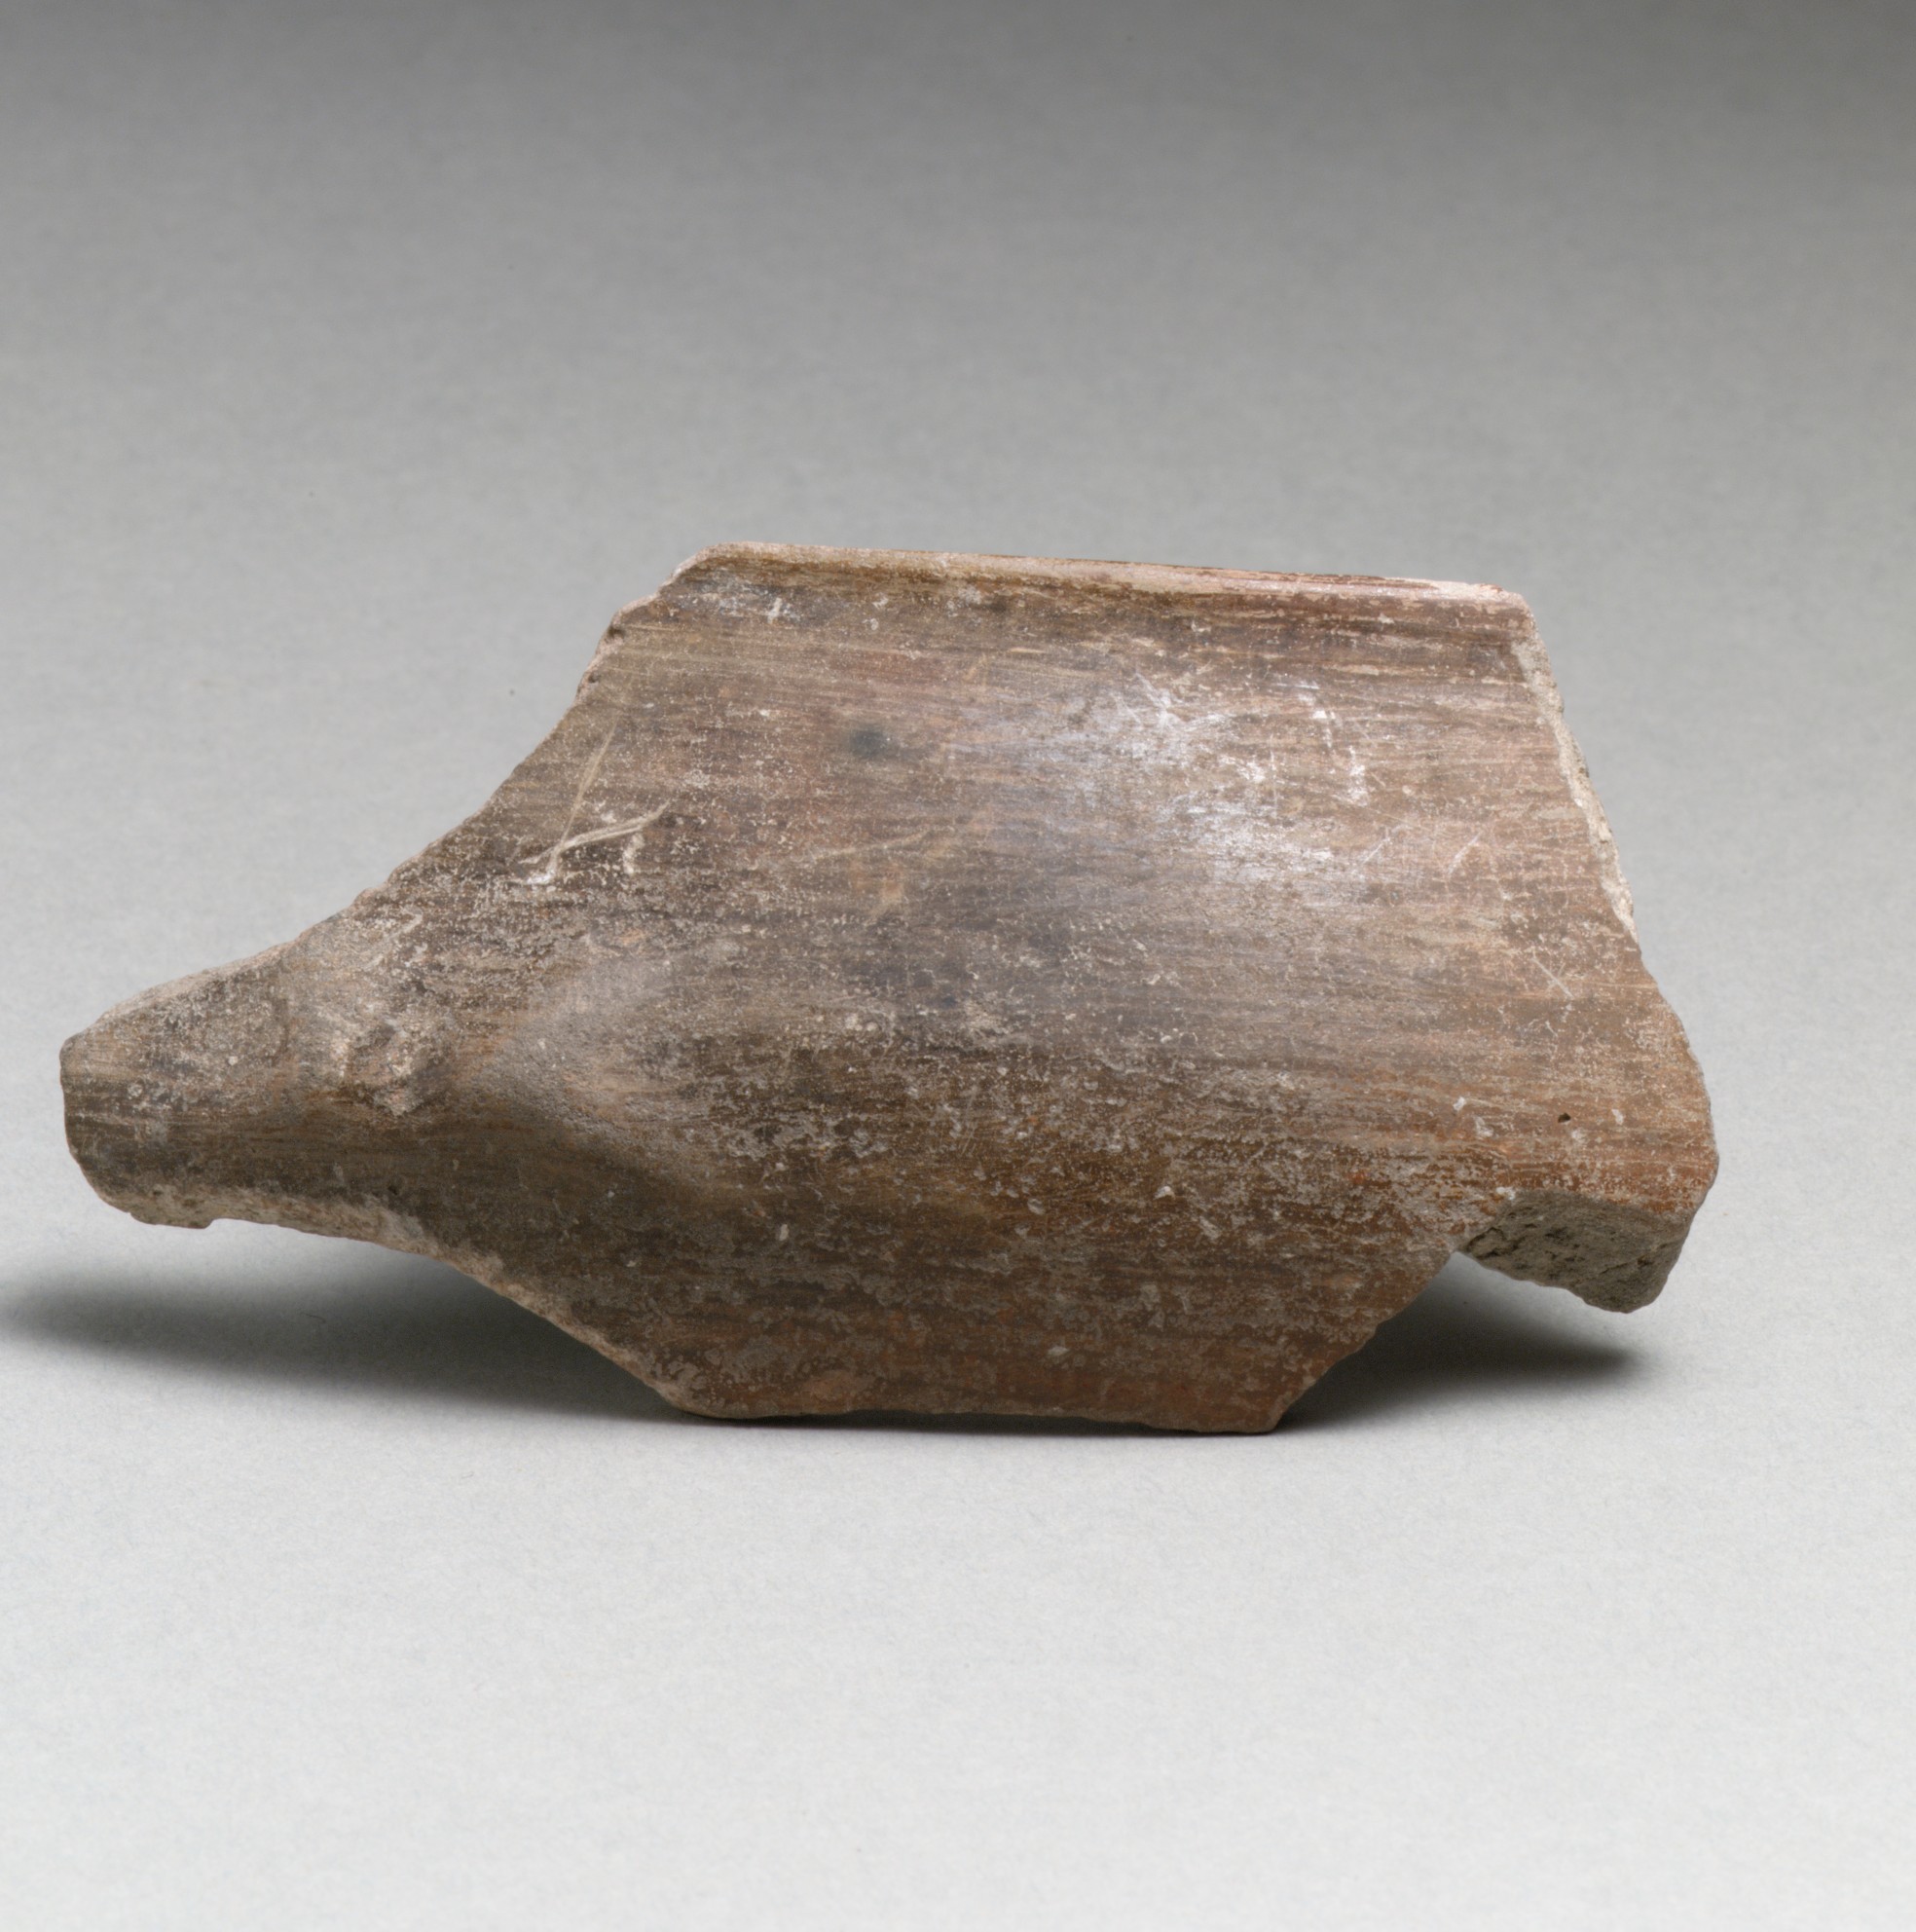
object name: vase fragment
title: Terracotta rim fragment of a bowl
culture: cretan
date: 5700-3600 BCE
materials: terracotta